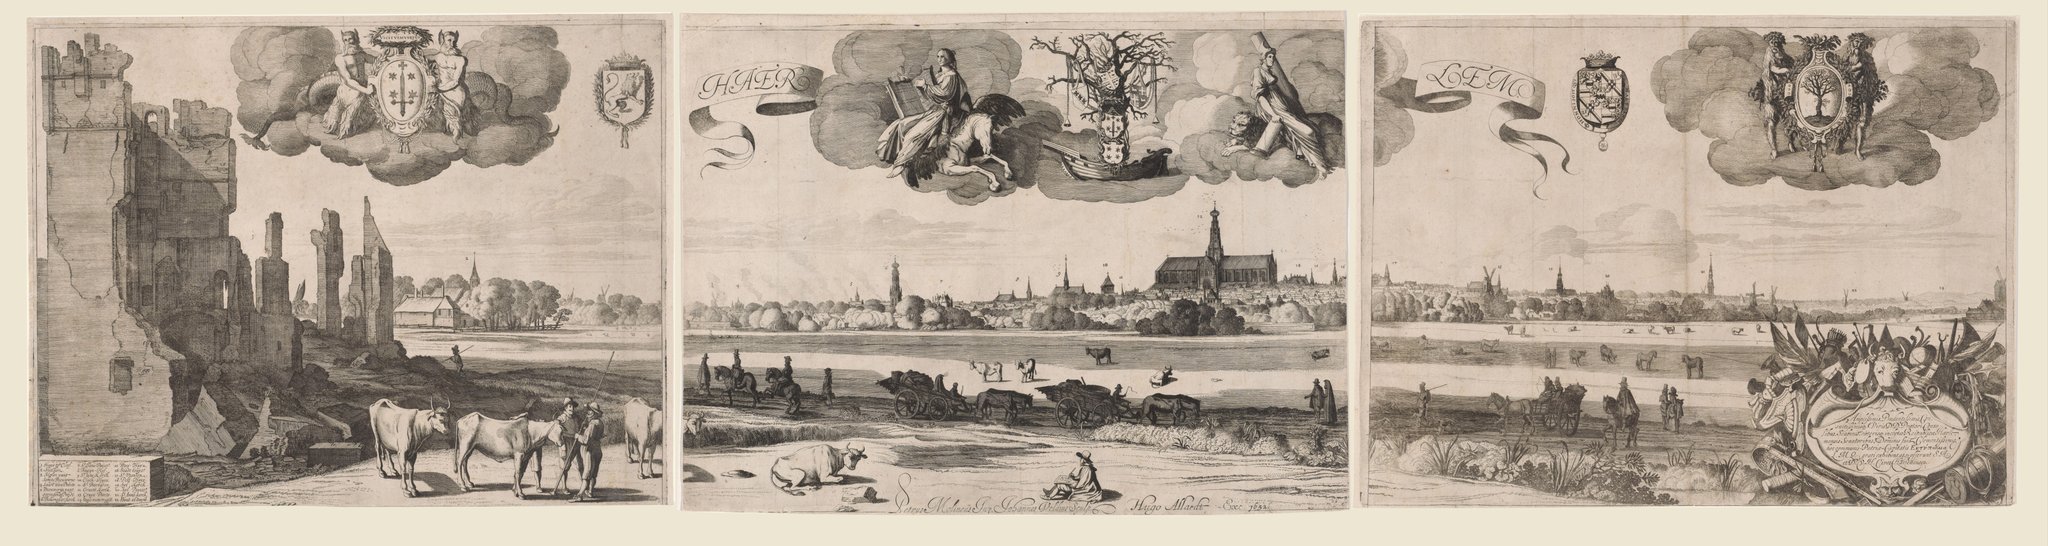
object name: print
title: Gezicht op Haarlem C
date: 1652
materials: paper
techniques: etching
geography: northern netherlands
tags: fortitude, 'fortitudo' ~ one of the four cardinal virtues, prudence, 'prudentia'; 'prudenza' (ripa) ~ one of the four cardinal virtues, cattle driving, cattle driver, draughtsman at work - cc - out of doors, prospect of city, town panorama, silhouette of city, haarlem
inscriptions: inscription: ‘HAER / LEM’, dedication: ‘Amplissimus. Prudentissimis...offerunt. S.A. (= Samuel Ampzing) et D.V.H. (= David van Horenbeek) Cives Harlemenses’, number: ‘1-23’, signature and address: ‘Petrus Molineus Inv. Johannes veldius sculp. Hugo Allardt Exc. 1652’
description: Gezicht op Haarlem, gezien vanaf het noorden, met personificaties van Voorzichtigheid en Kracht in een wolk middenboven. Linksboven wapen van Haarlem, gedragen door twee harpijen, met de inscriptie: Vicit Vim Virtus. De gebouwen (Sint-Bavokerk in het midden) zijn voorzien van nummers. Linksonder, op een steen, de namen van de betreffende gebouwen in de legenda. Op de voorgrond links een herder met kudde koeien bij een ruïne, in het midden een tekenaar en rechts een cartouche met opdracht in Latijn. Op het tweede plan koetsen, ruiters en wandelaars.